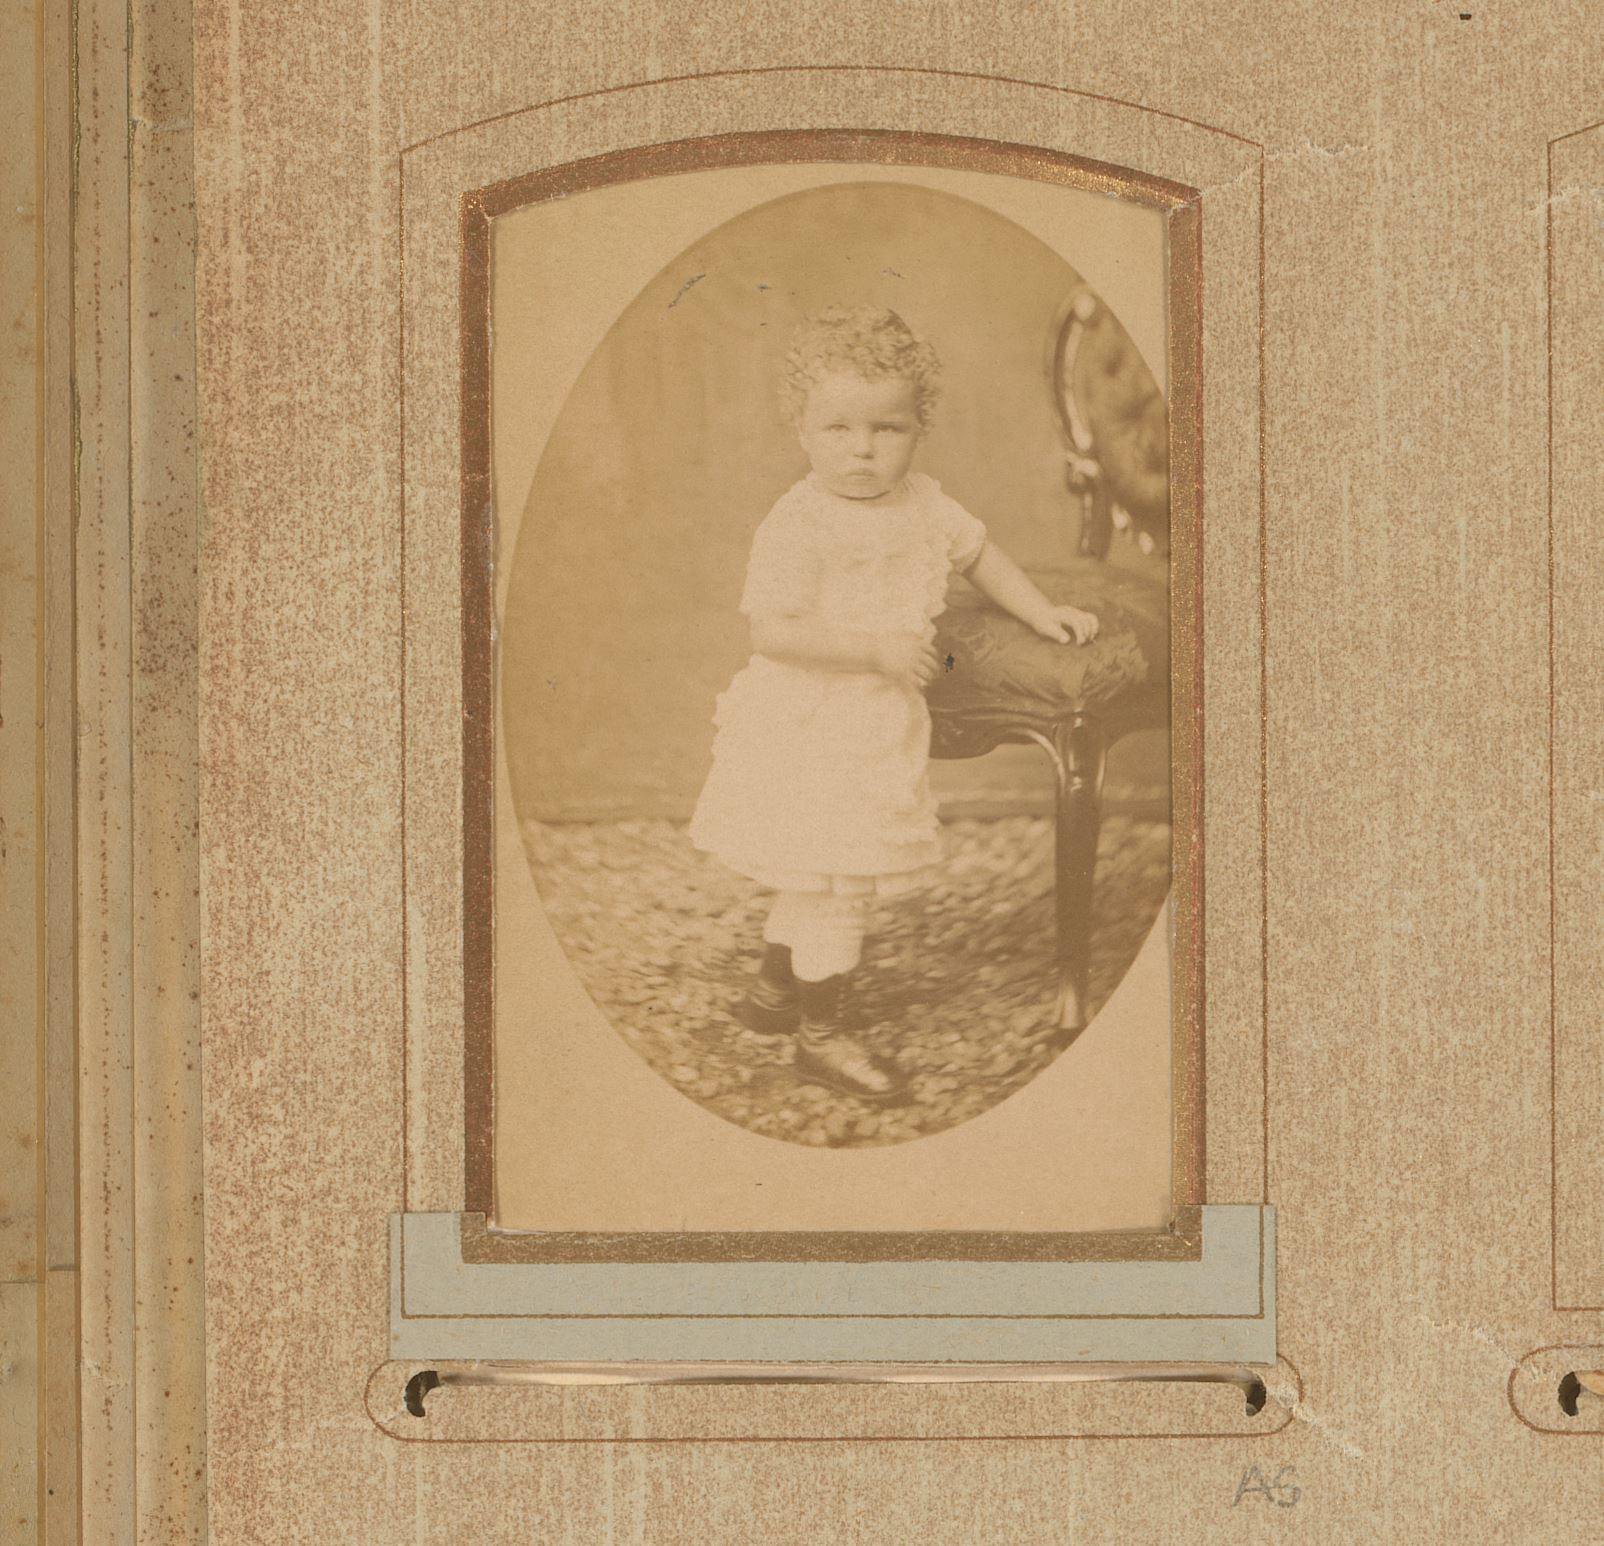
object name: carte de visite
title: Portret van een peuter, staand bij een stoel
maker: jacob kuyper (1851-1919)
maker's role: fotograaf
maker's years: 1851-1919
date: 1870-1900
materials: cardboard, photographic support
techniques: albumen print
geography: zaandam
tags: historical persons, tot, toddler ~ the ages of man, chair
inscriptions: inscription: ‘Photografisch Atelier/ van/ J. Kuyper/ voorheen:/ J. Breebaard/ ZAANDAM/ (westzÿde bÿ de Kerk)/ Salon Portretten naar alle bestaande/ Photographien./ De platen blijven voor nabestellingen/ bewaard.’